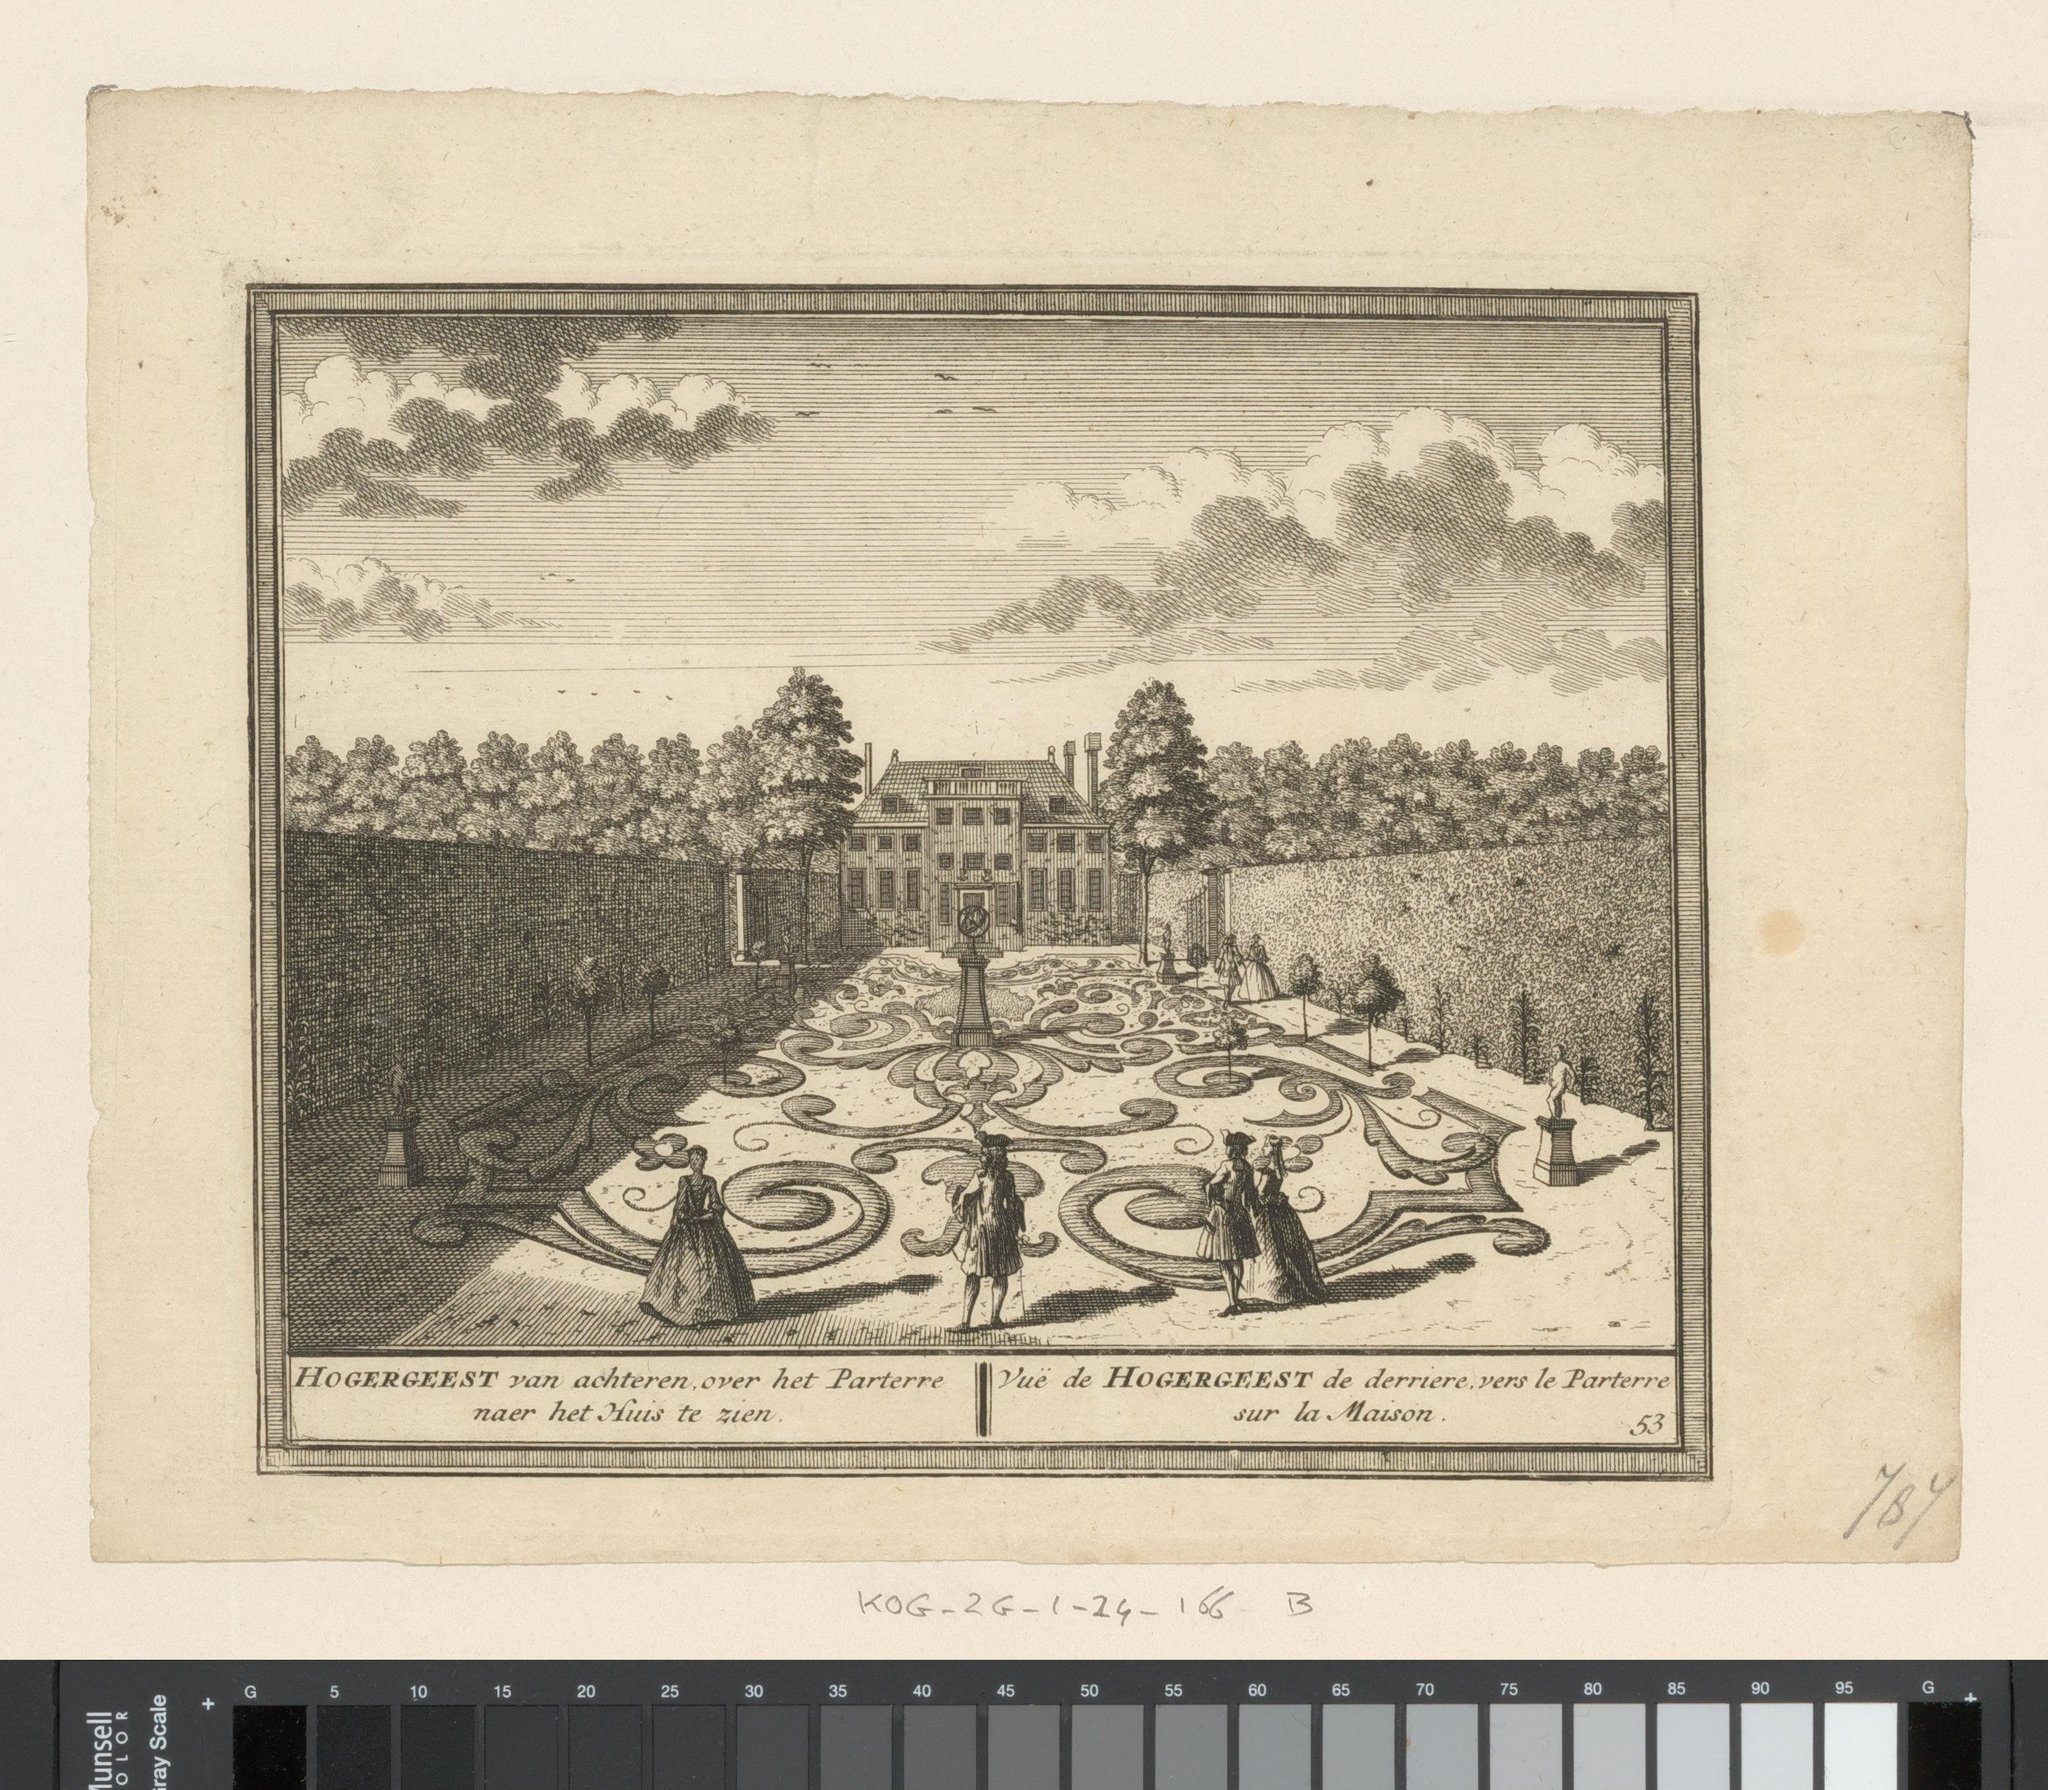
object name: print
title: Gezicht op de tuin van de buitenplaats Hogergeest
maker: hendrik de leth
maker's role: draughtsman, print maker, publisher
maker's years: 1703-1766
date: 1729-1732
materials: paper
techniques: engraving, etching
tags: french or architectonic garden; formal garden, country-house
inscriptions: stamp, collector's mark: Lugt 1641, stamp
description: De achterziijde van het huis Hogergeest, toebehorende aan de heer Adam van Rijn, schepen in Amsterdam. Rechtsonder genummerd: 53. Onderwerpsrubrieken binnen de Atlas Zeden en Gewoonten: Zeden en Gewoonten in Engeren Zin, De Woning, Oude Nederlandsche Tuinkunst. De 18de eeuw. Tuinen in Kennemerland, le Nôtre stijl.